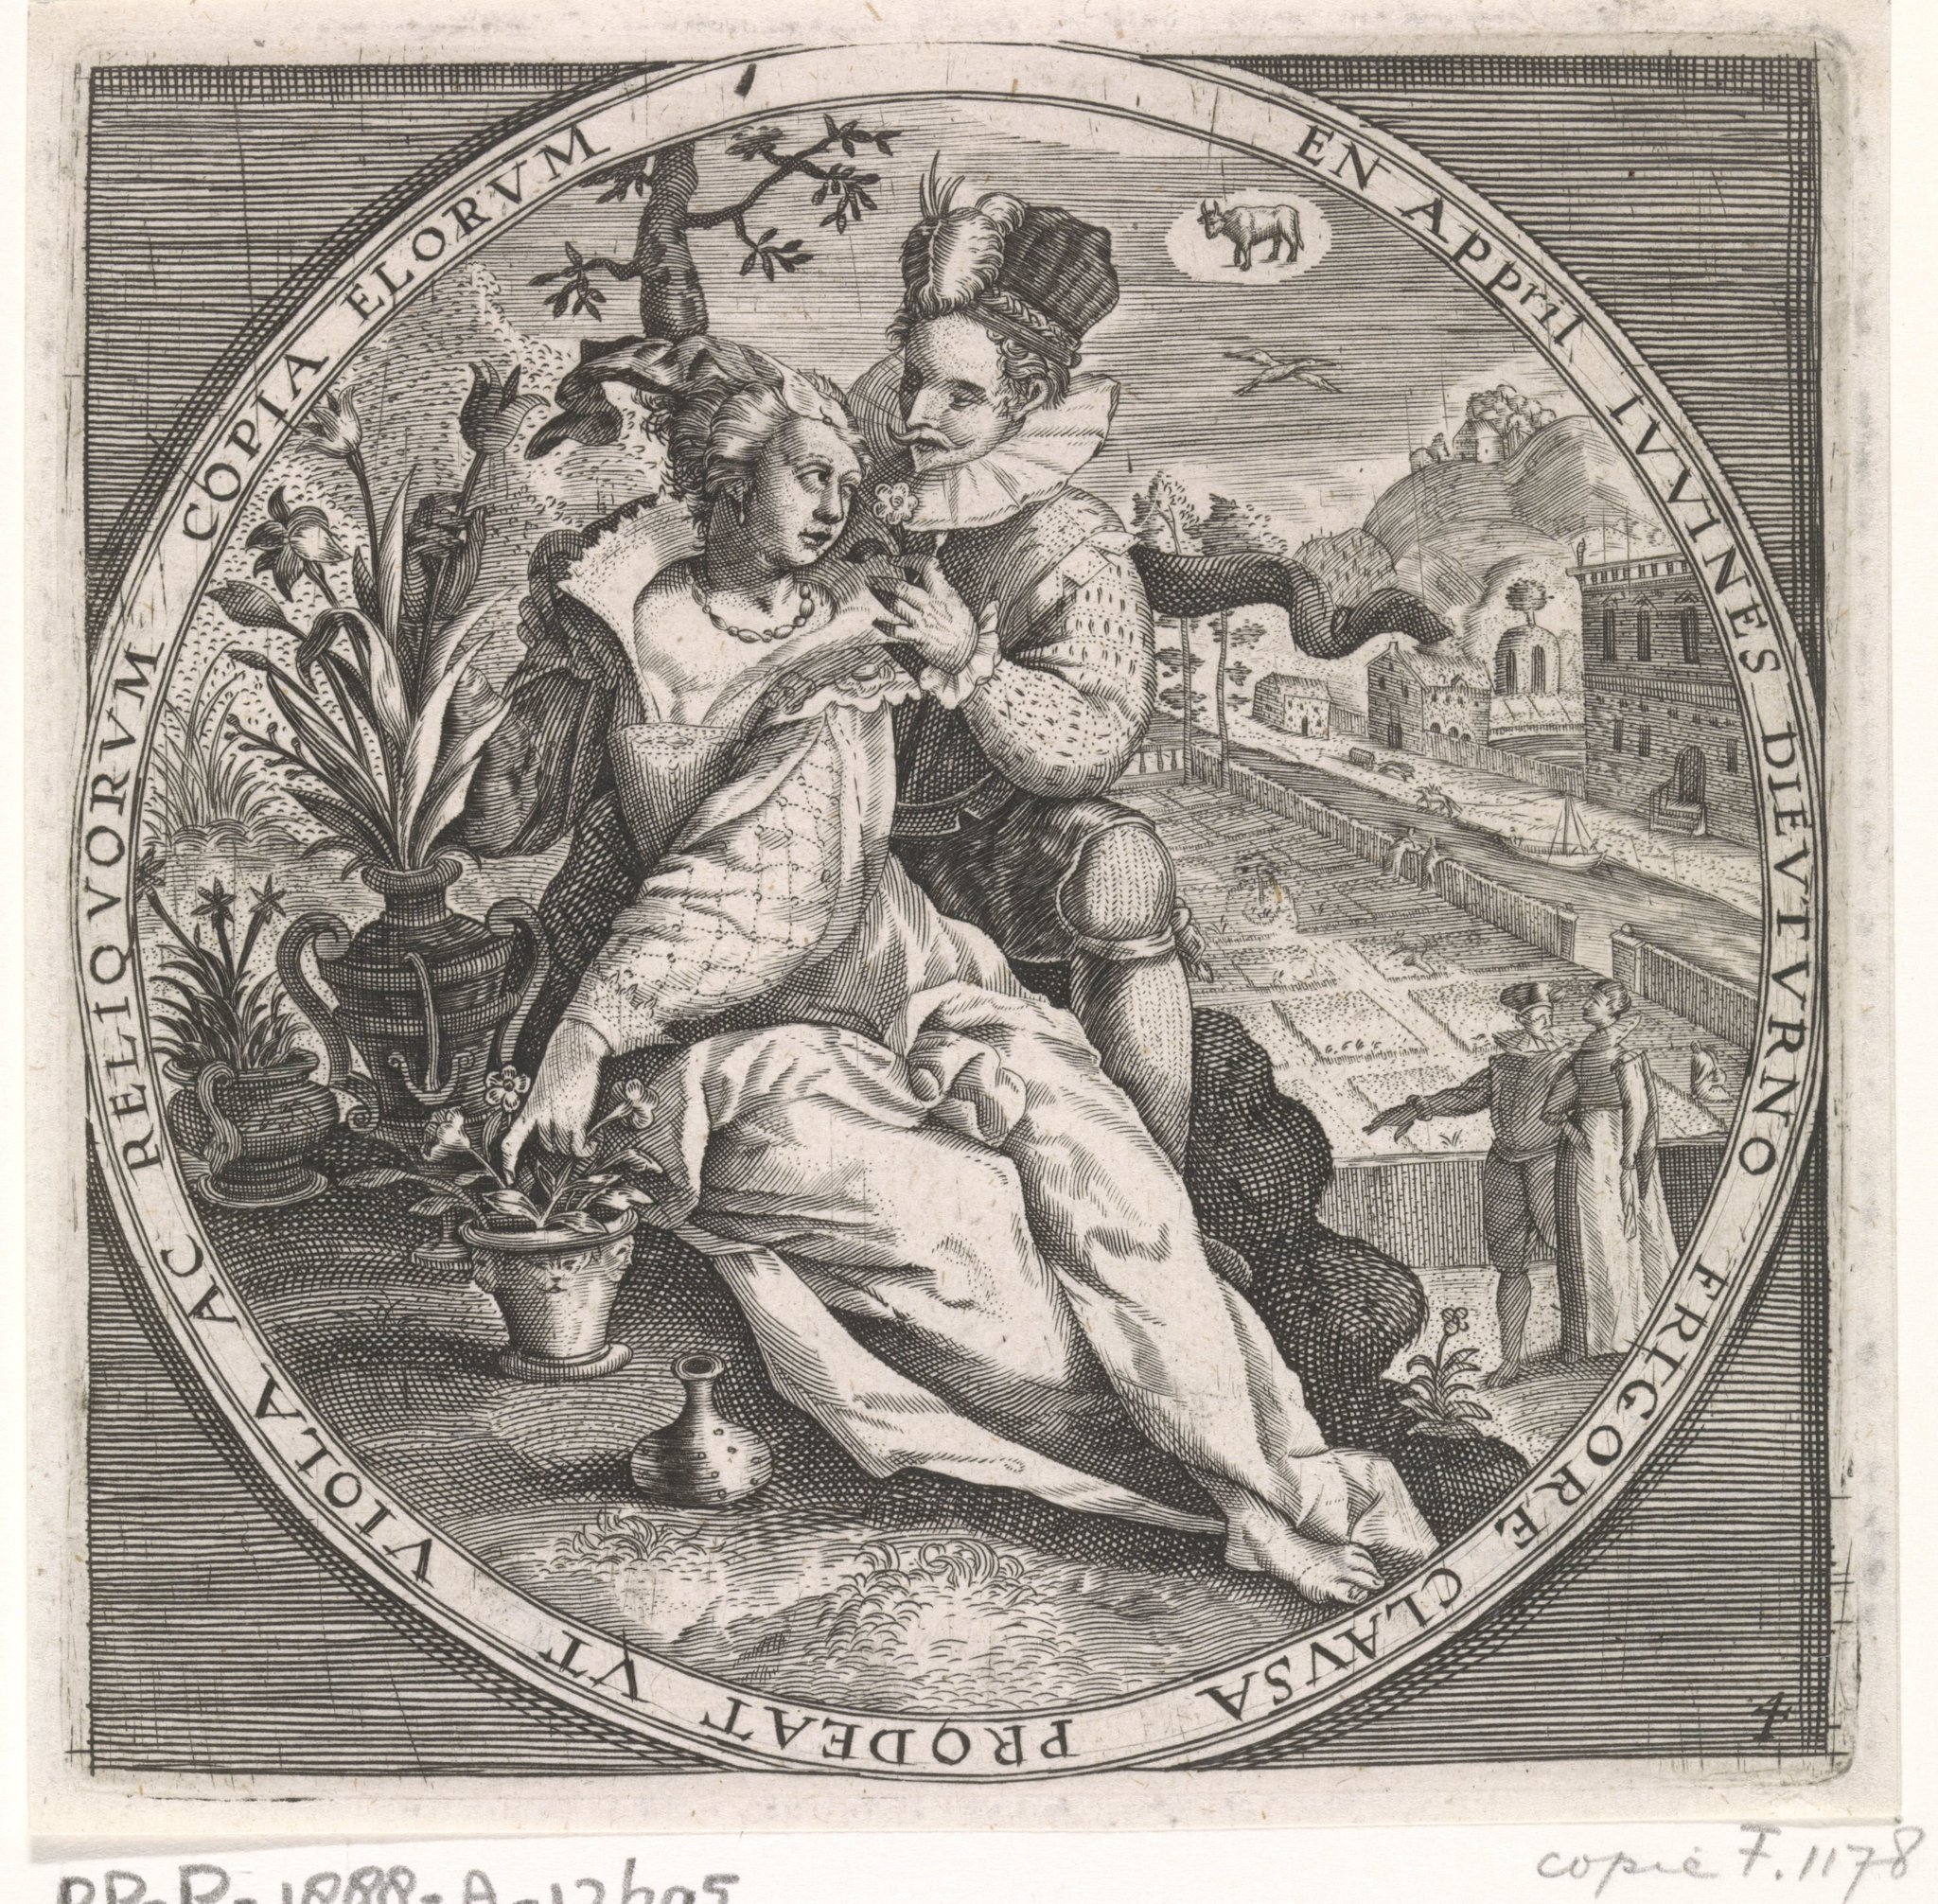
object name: print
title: Schemata XII. Mensium (...)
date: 1574-1687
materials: paper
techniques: engraving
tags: garden, couple of lovers, april and its 'labours' (+ with zodiacal signs)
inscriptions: collector's mark: Lugt 2228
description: De maand april: minnend paar dat in een tuin zit te midden van bloemen. Rechtsboven het teken van de dierenriem dat bij de maand april hoort: Stier. De prent heeft een omlijsting met een randschrift in het Latijn dat verwijst naar de invloed van de maand april. Kopie in spiegelbeeld naar de gelijknamige prent van Crispijn van de Passe (I).